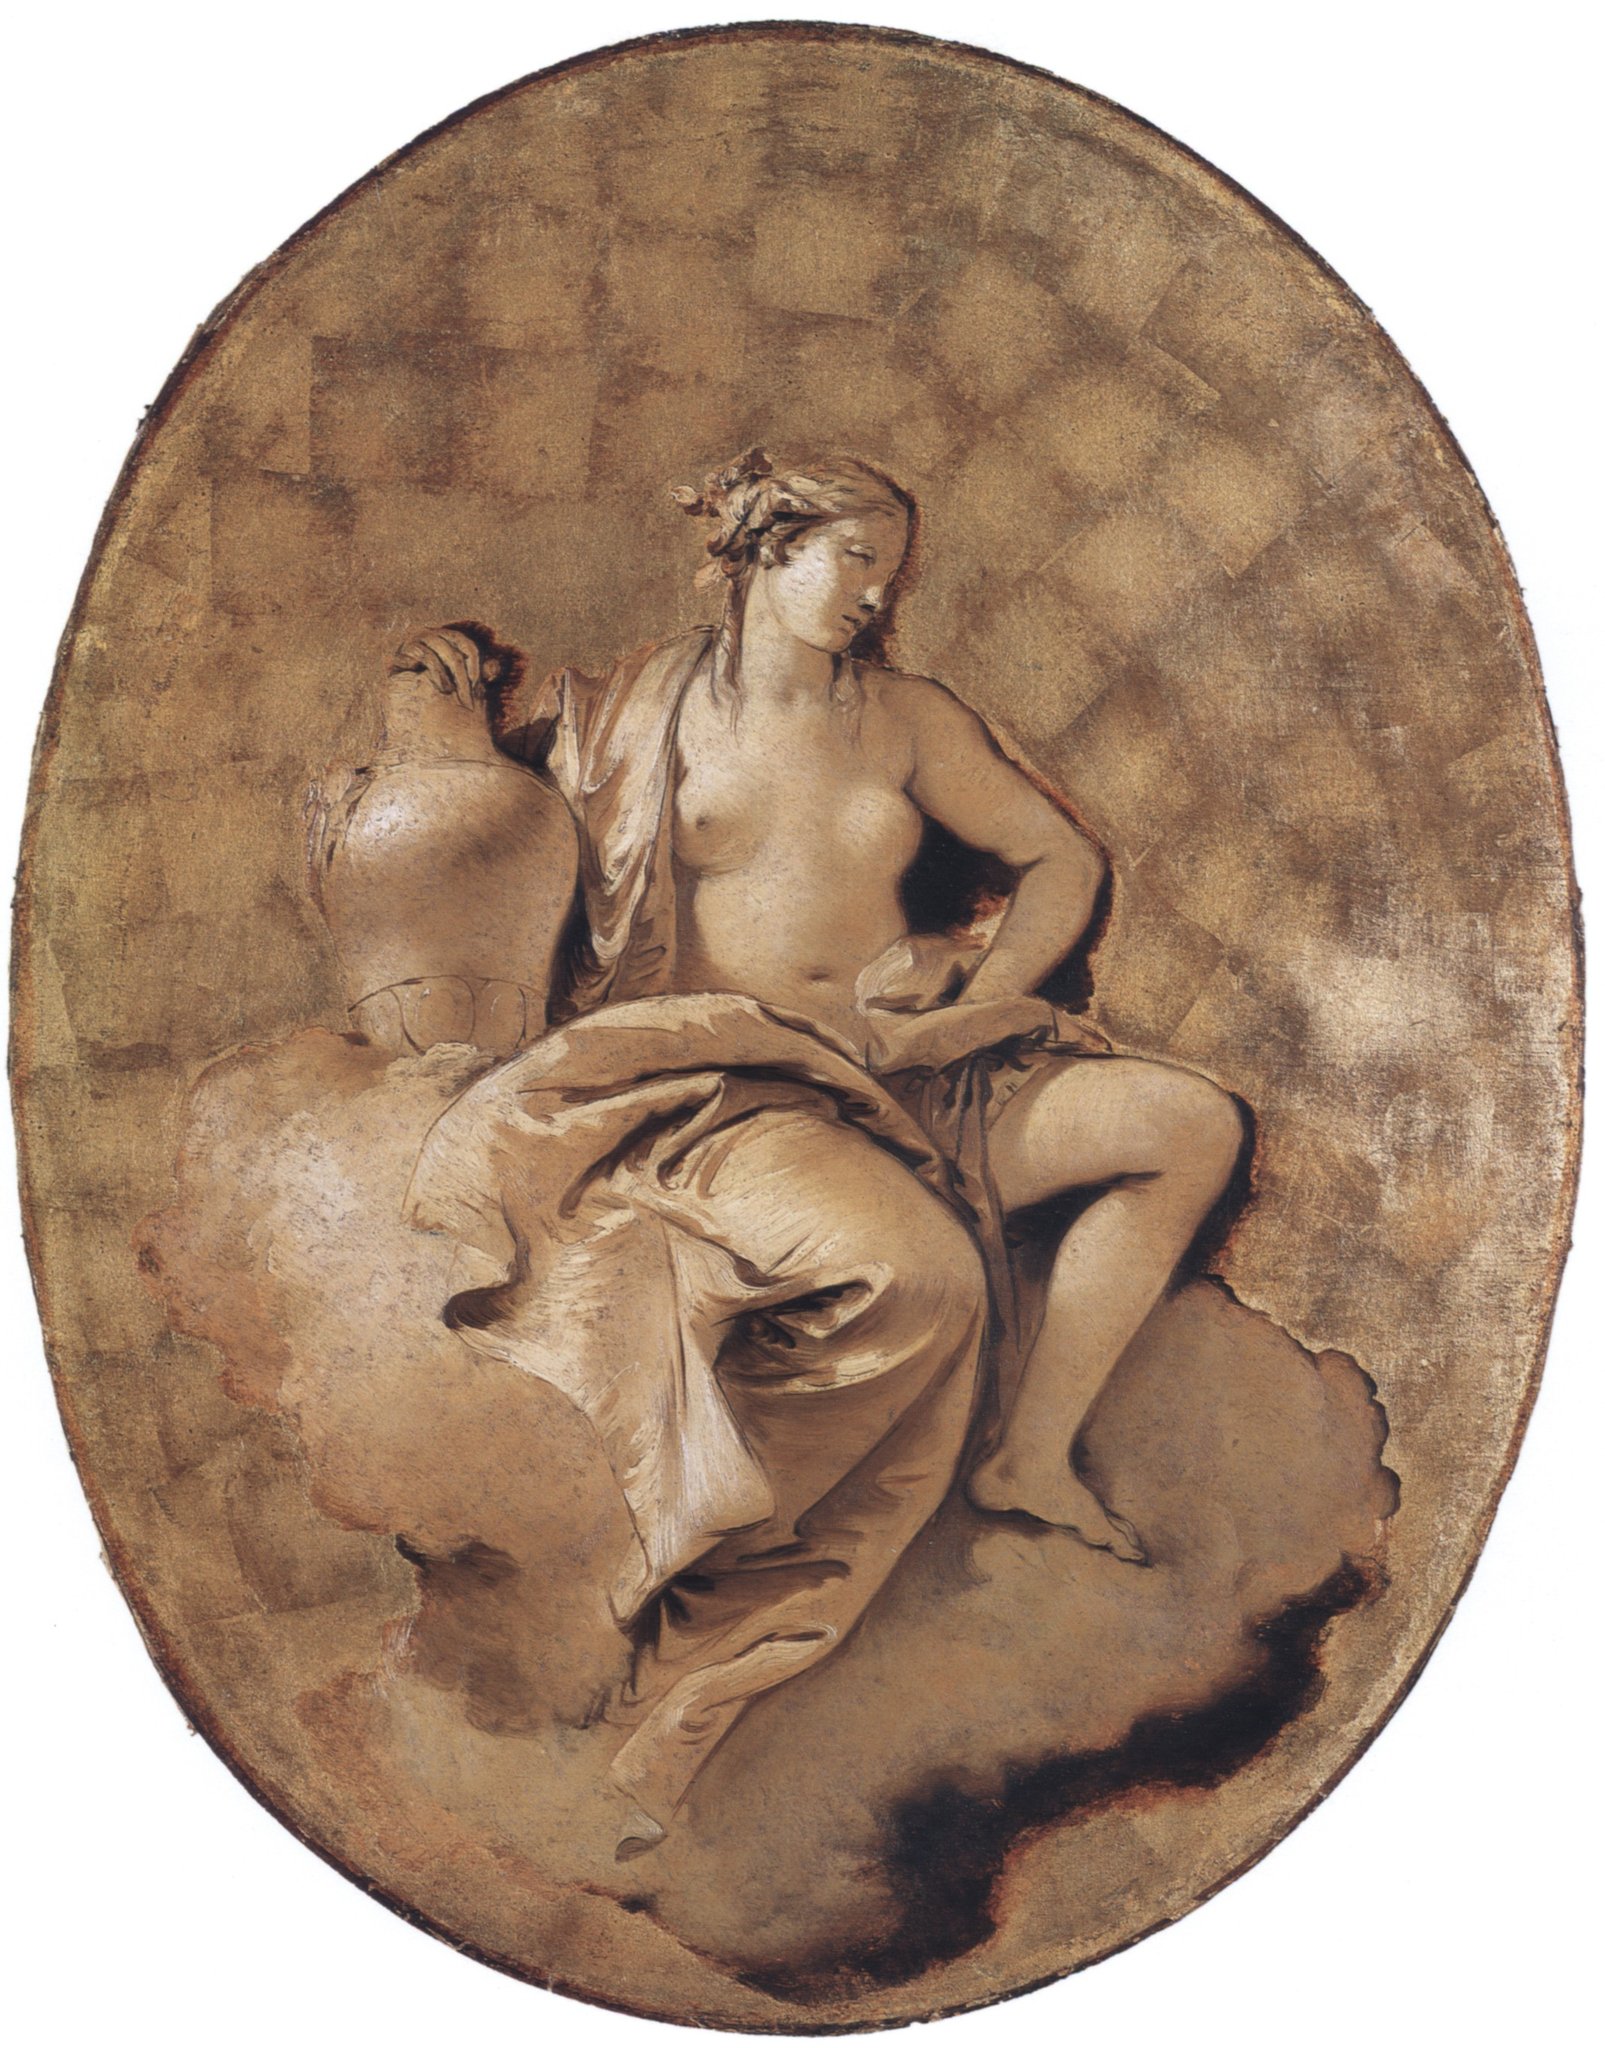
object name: painting, grisaille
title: A Female Allegorical Figure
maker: giovanni battista tiepolo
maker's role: artist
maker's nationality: italian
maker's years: 1696-1770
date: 1740-1750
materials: canvas, gold leaf, oil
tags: female nudes,allegory